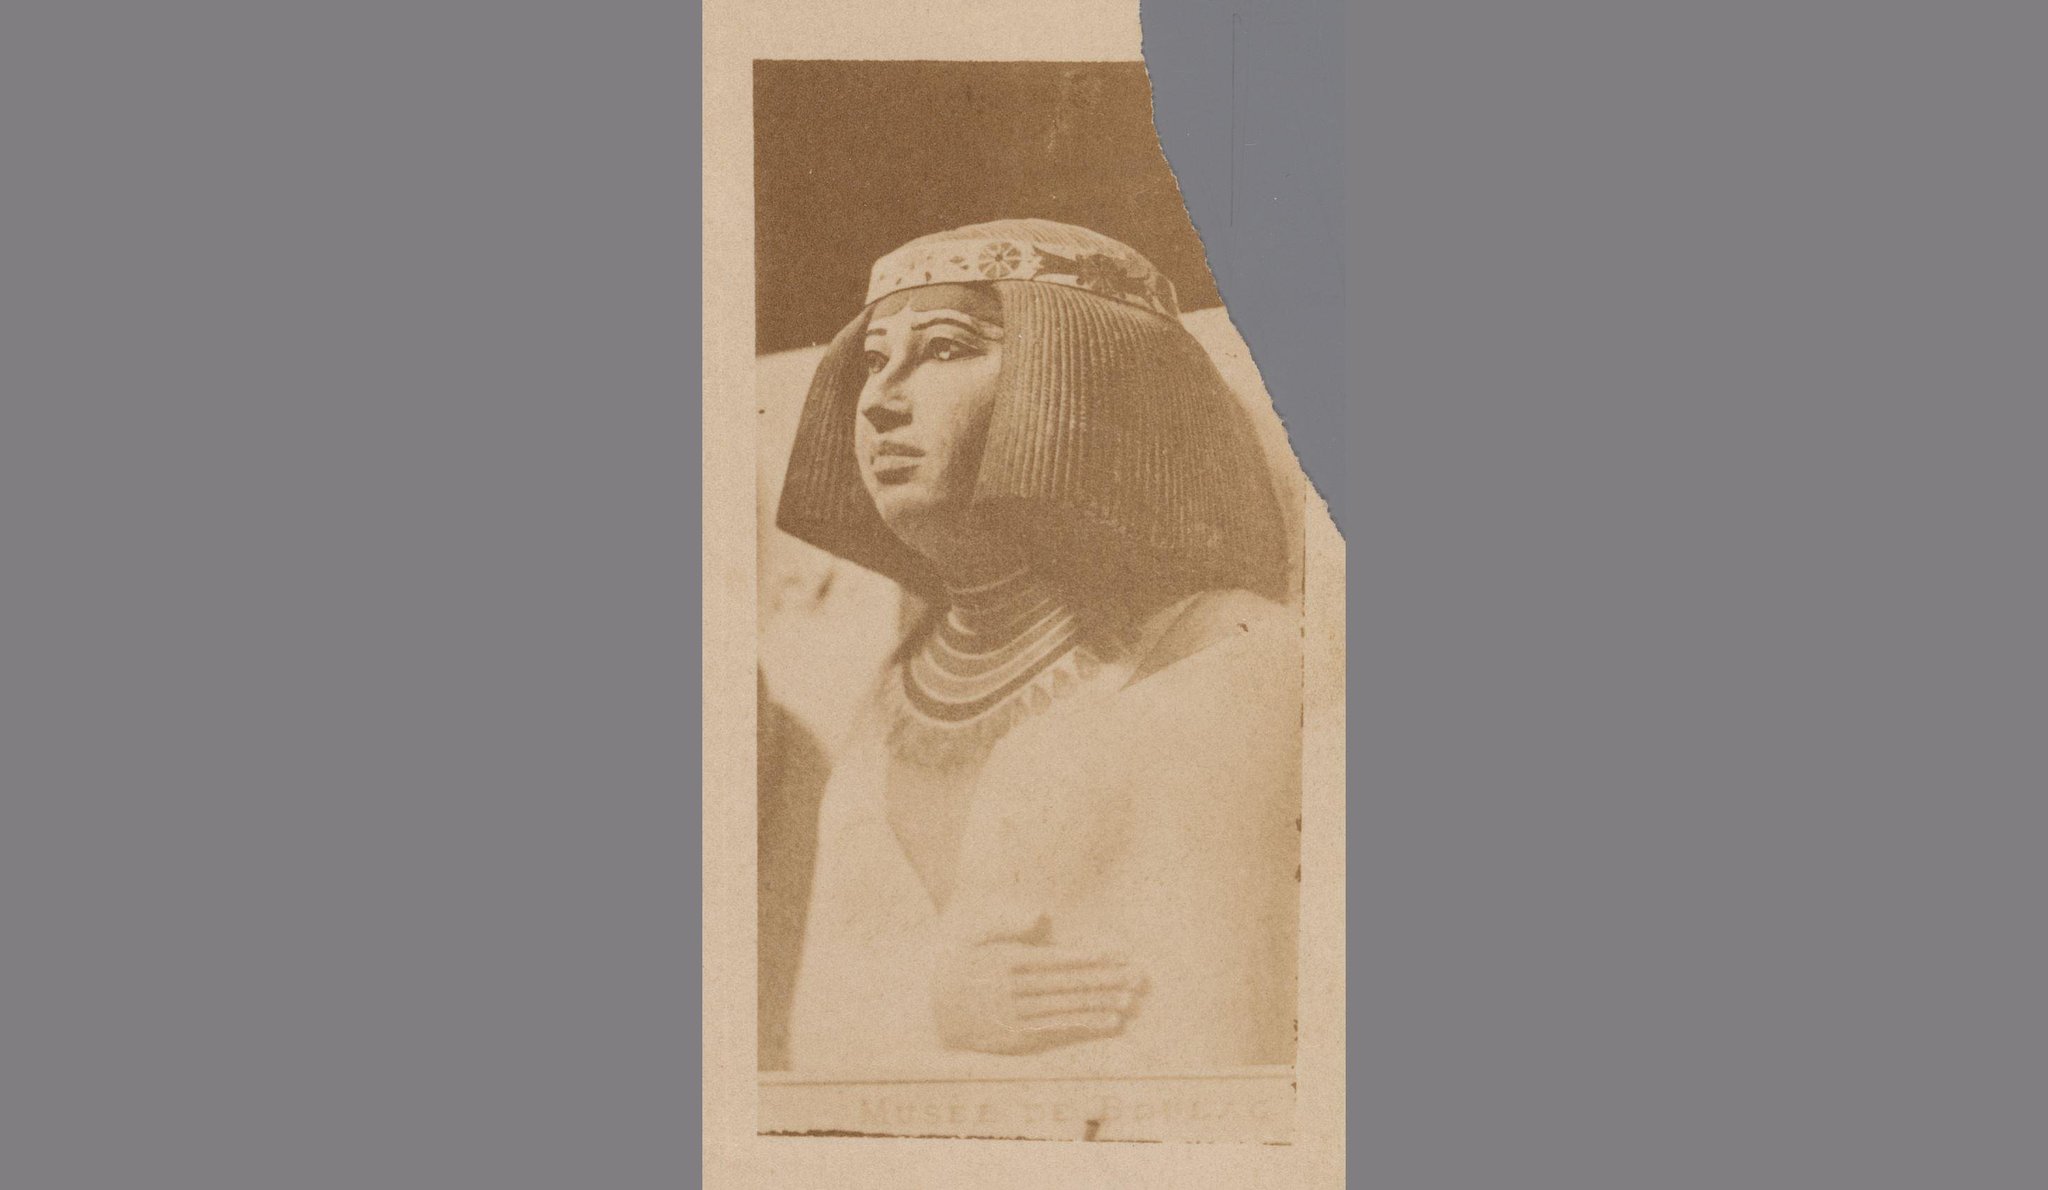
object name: photograph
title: Detail van een Egyptische sculptuur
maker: Anonymous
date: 1870-1890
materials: paper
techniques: albumen print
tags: piece of sculpture, reproduction of a piece of sculpture, egyptian religion